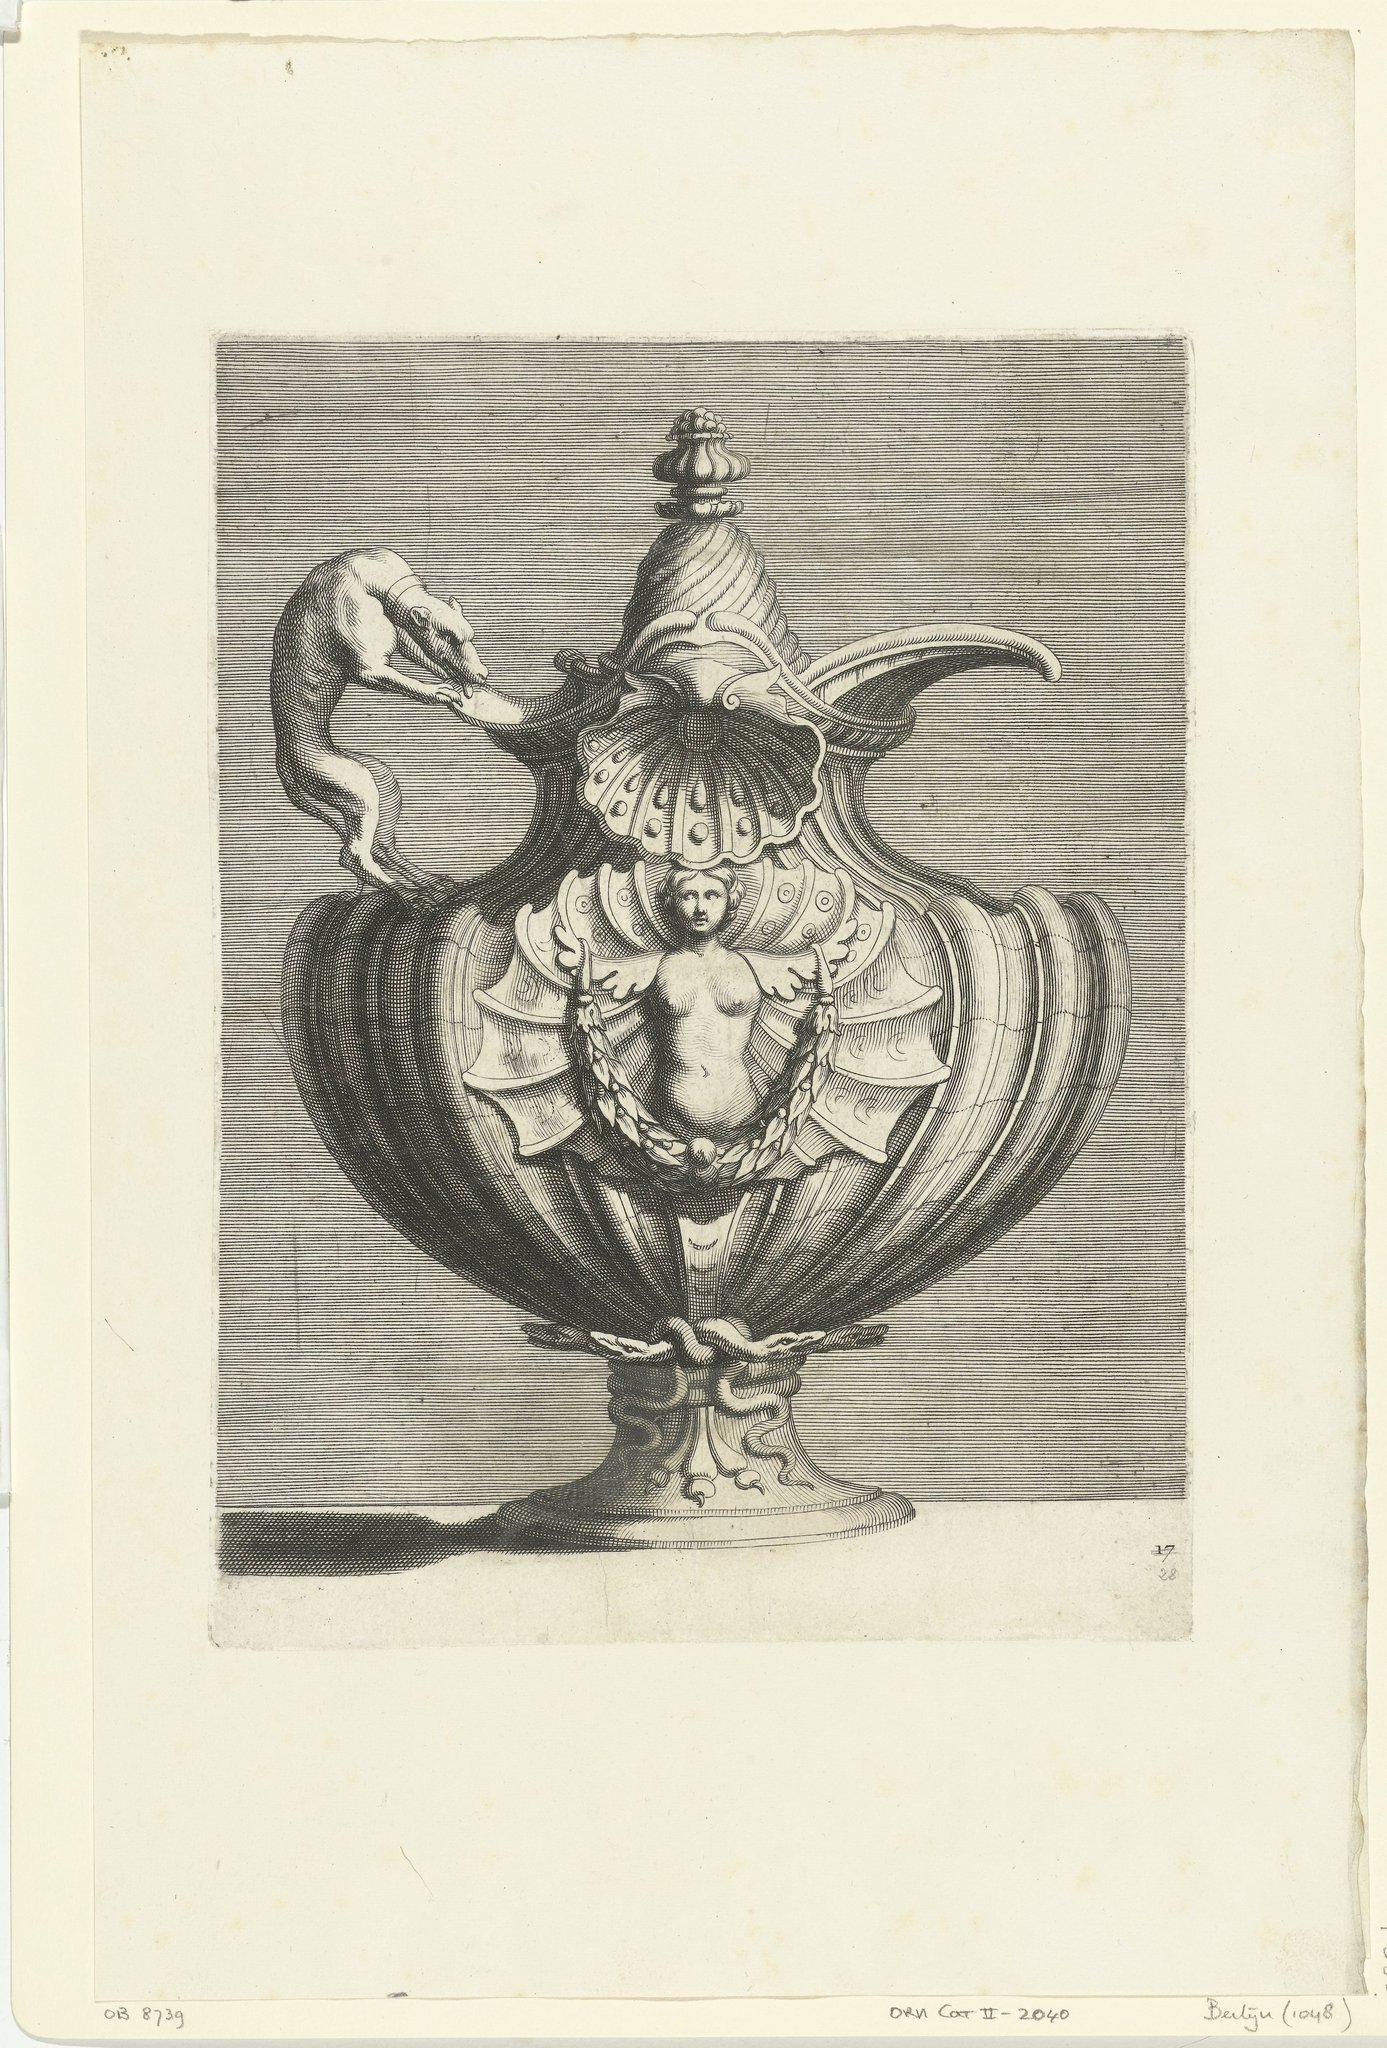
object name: print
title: Schenkkan met deksel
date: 1667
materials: paper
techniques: engraving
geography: paris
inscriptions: number: ‘28’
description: Het lichaam is gelobd met in het midden het bovenlichaam van een vrouw, het handvat heeft de vorm van een hond. Rechtsonder: 17, dit blad behoorde oorspronkelijk tot de eerste serie van de vazen, nummer 17 (?). Blad 28 uit serie van 25 bladen, genummerd: II (voorheen 26), 27-50.